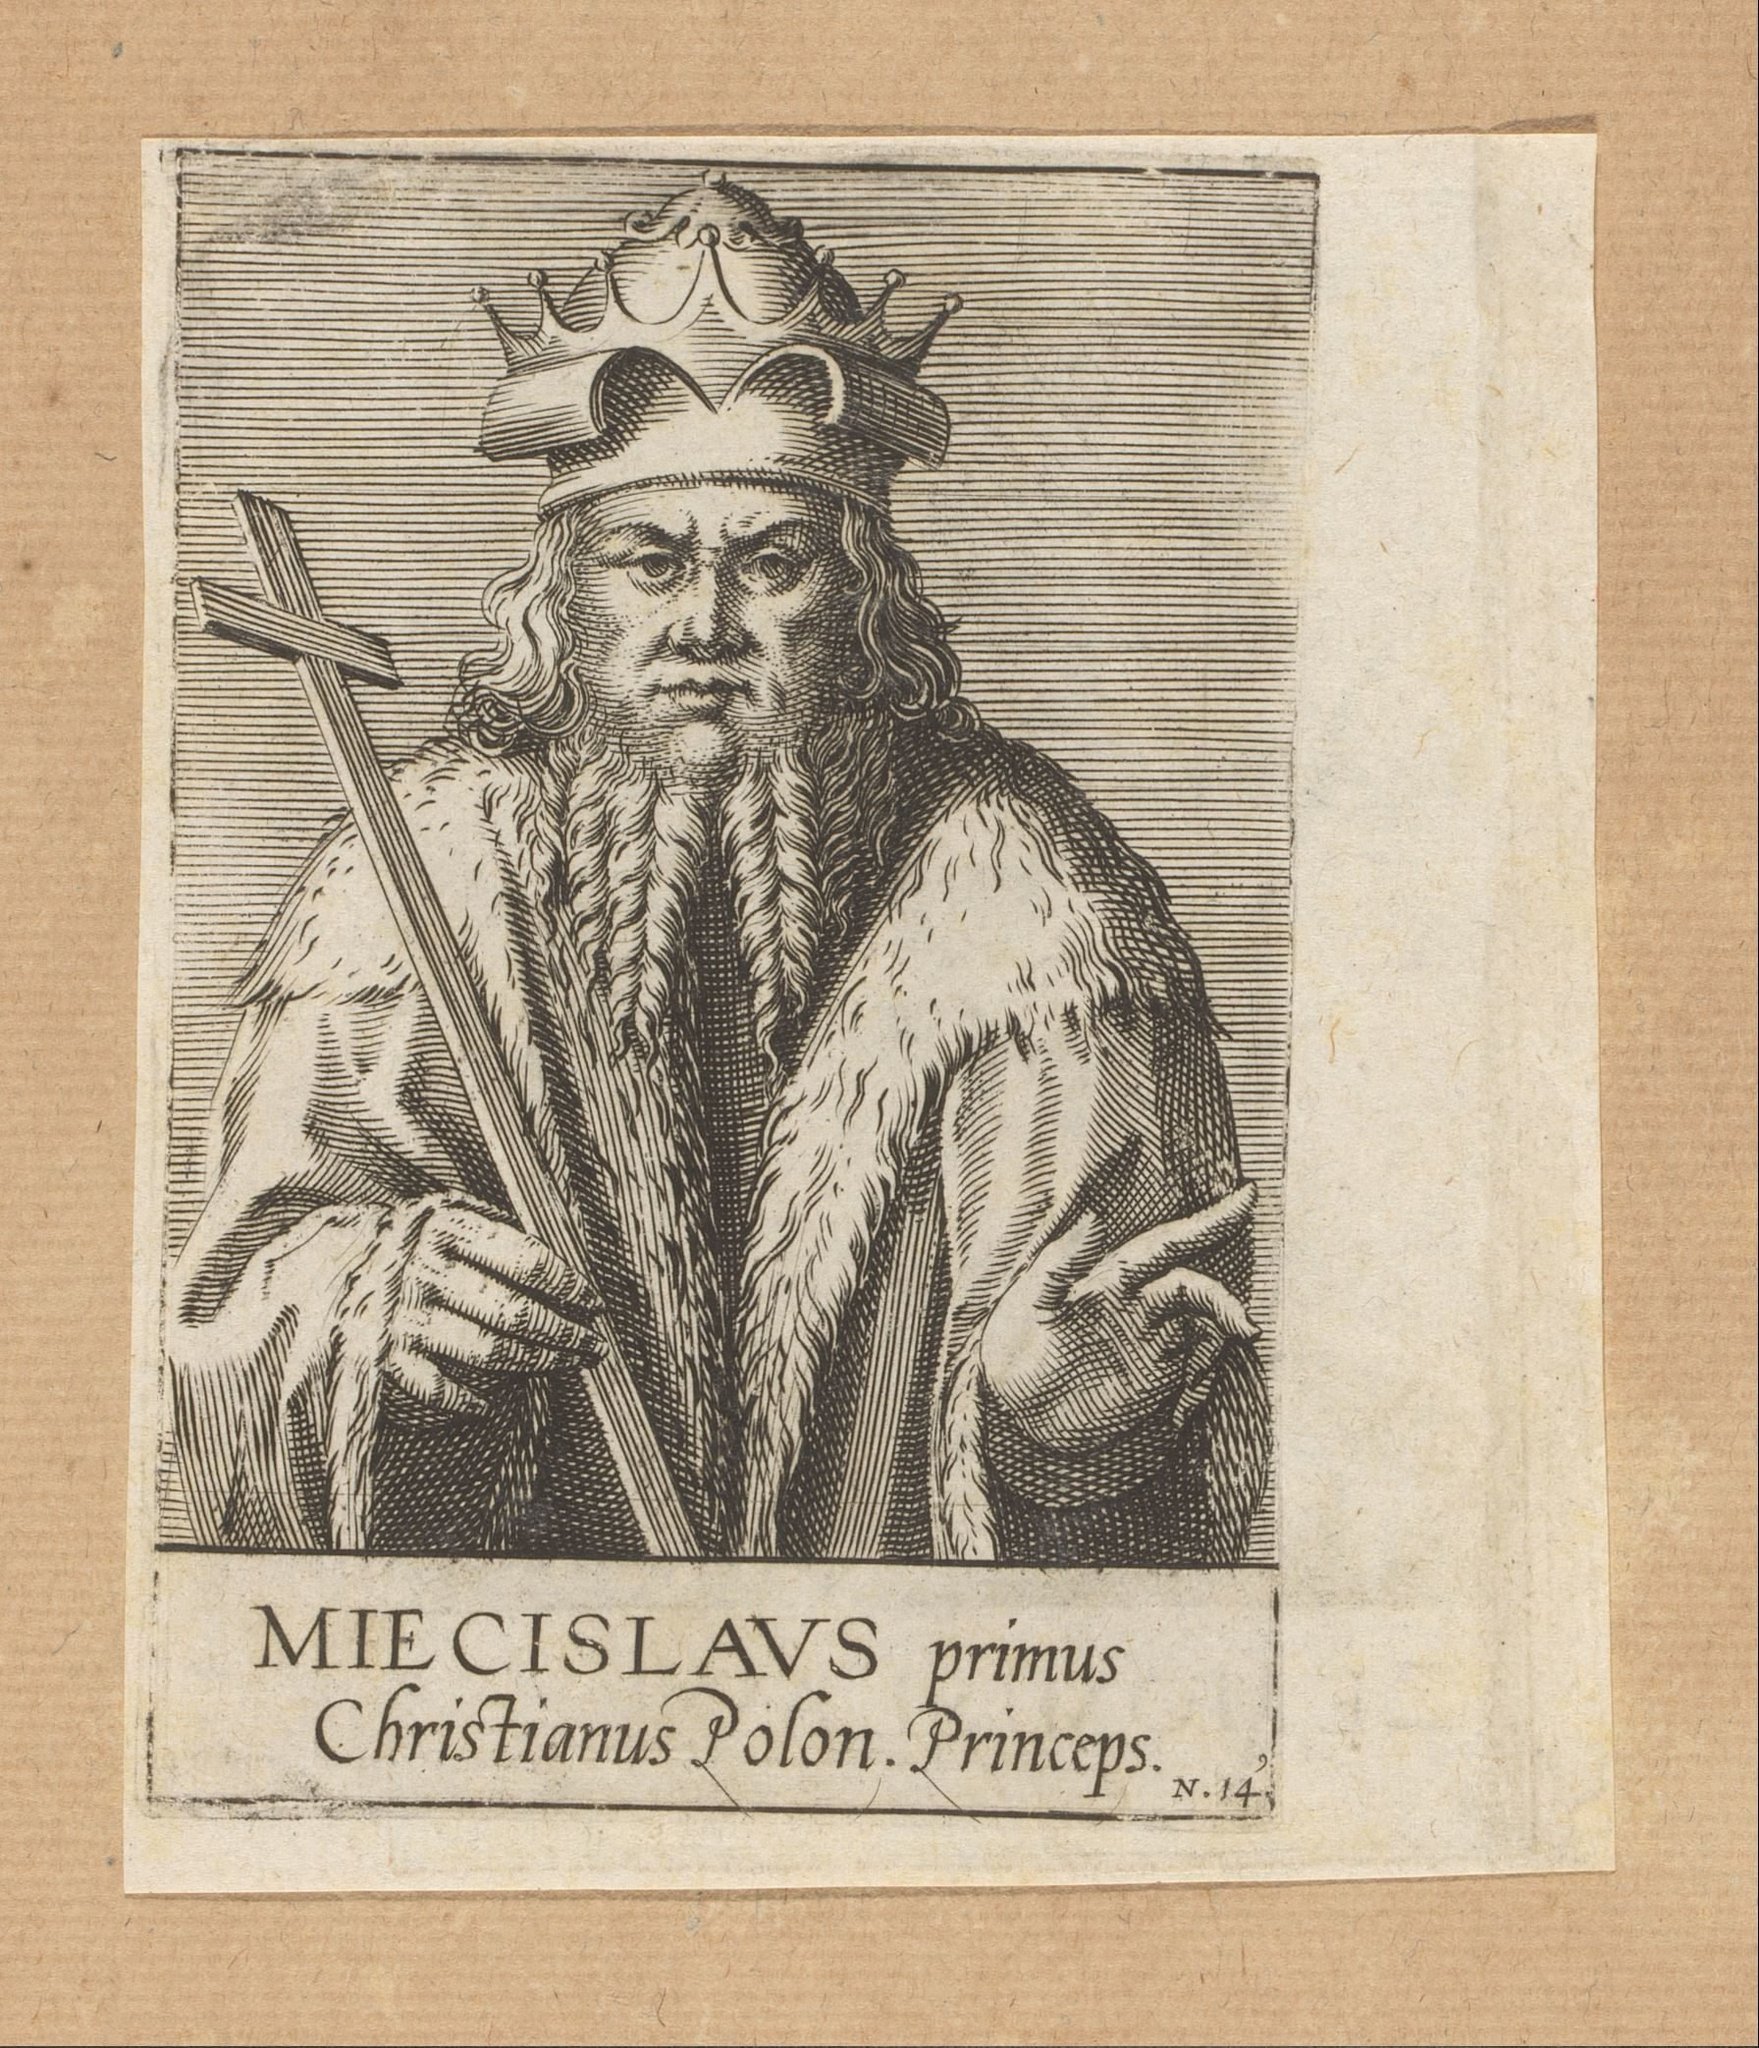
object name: album leaf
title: Portret van Mieszko I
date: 1574-1594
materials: paper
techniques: woodcut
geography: cologne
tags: politician, historical persons, king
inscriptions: collector's mark: Lugt 240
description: Prent gebruikt in: Mylius, Arnold. Principum et Regum Polonorum Imagines ad Vivum Expressae (...). Keulen: Gottfried von Kempen, 1594.